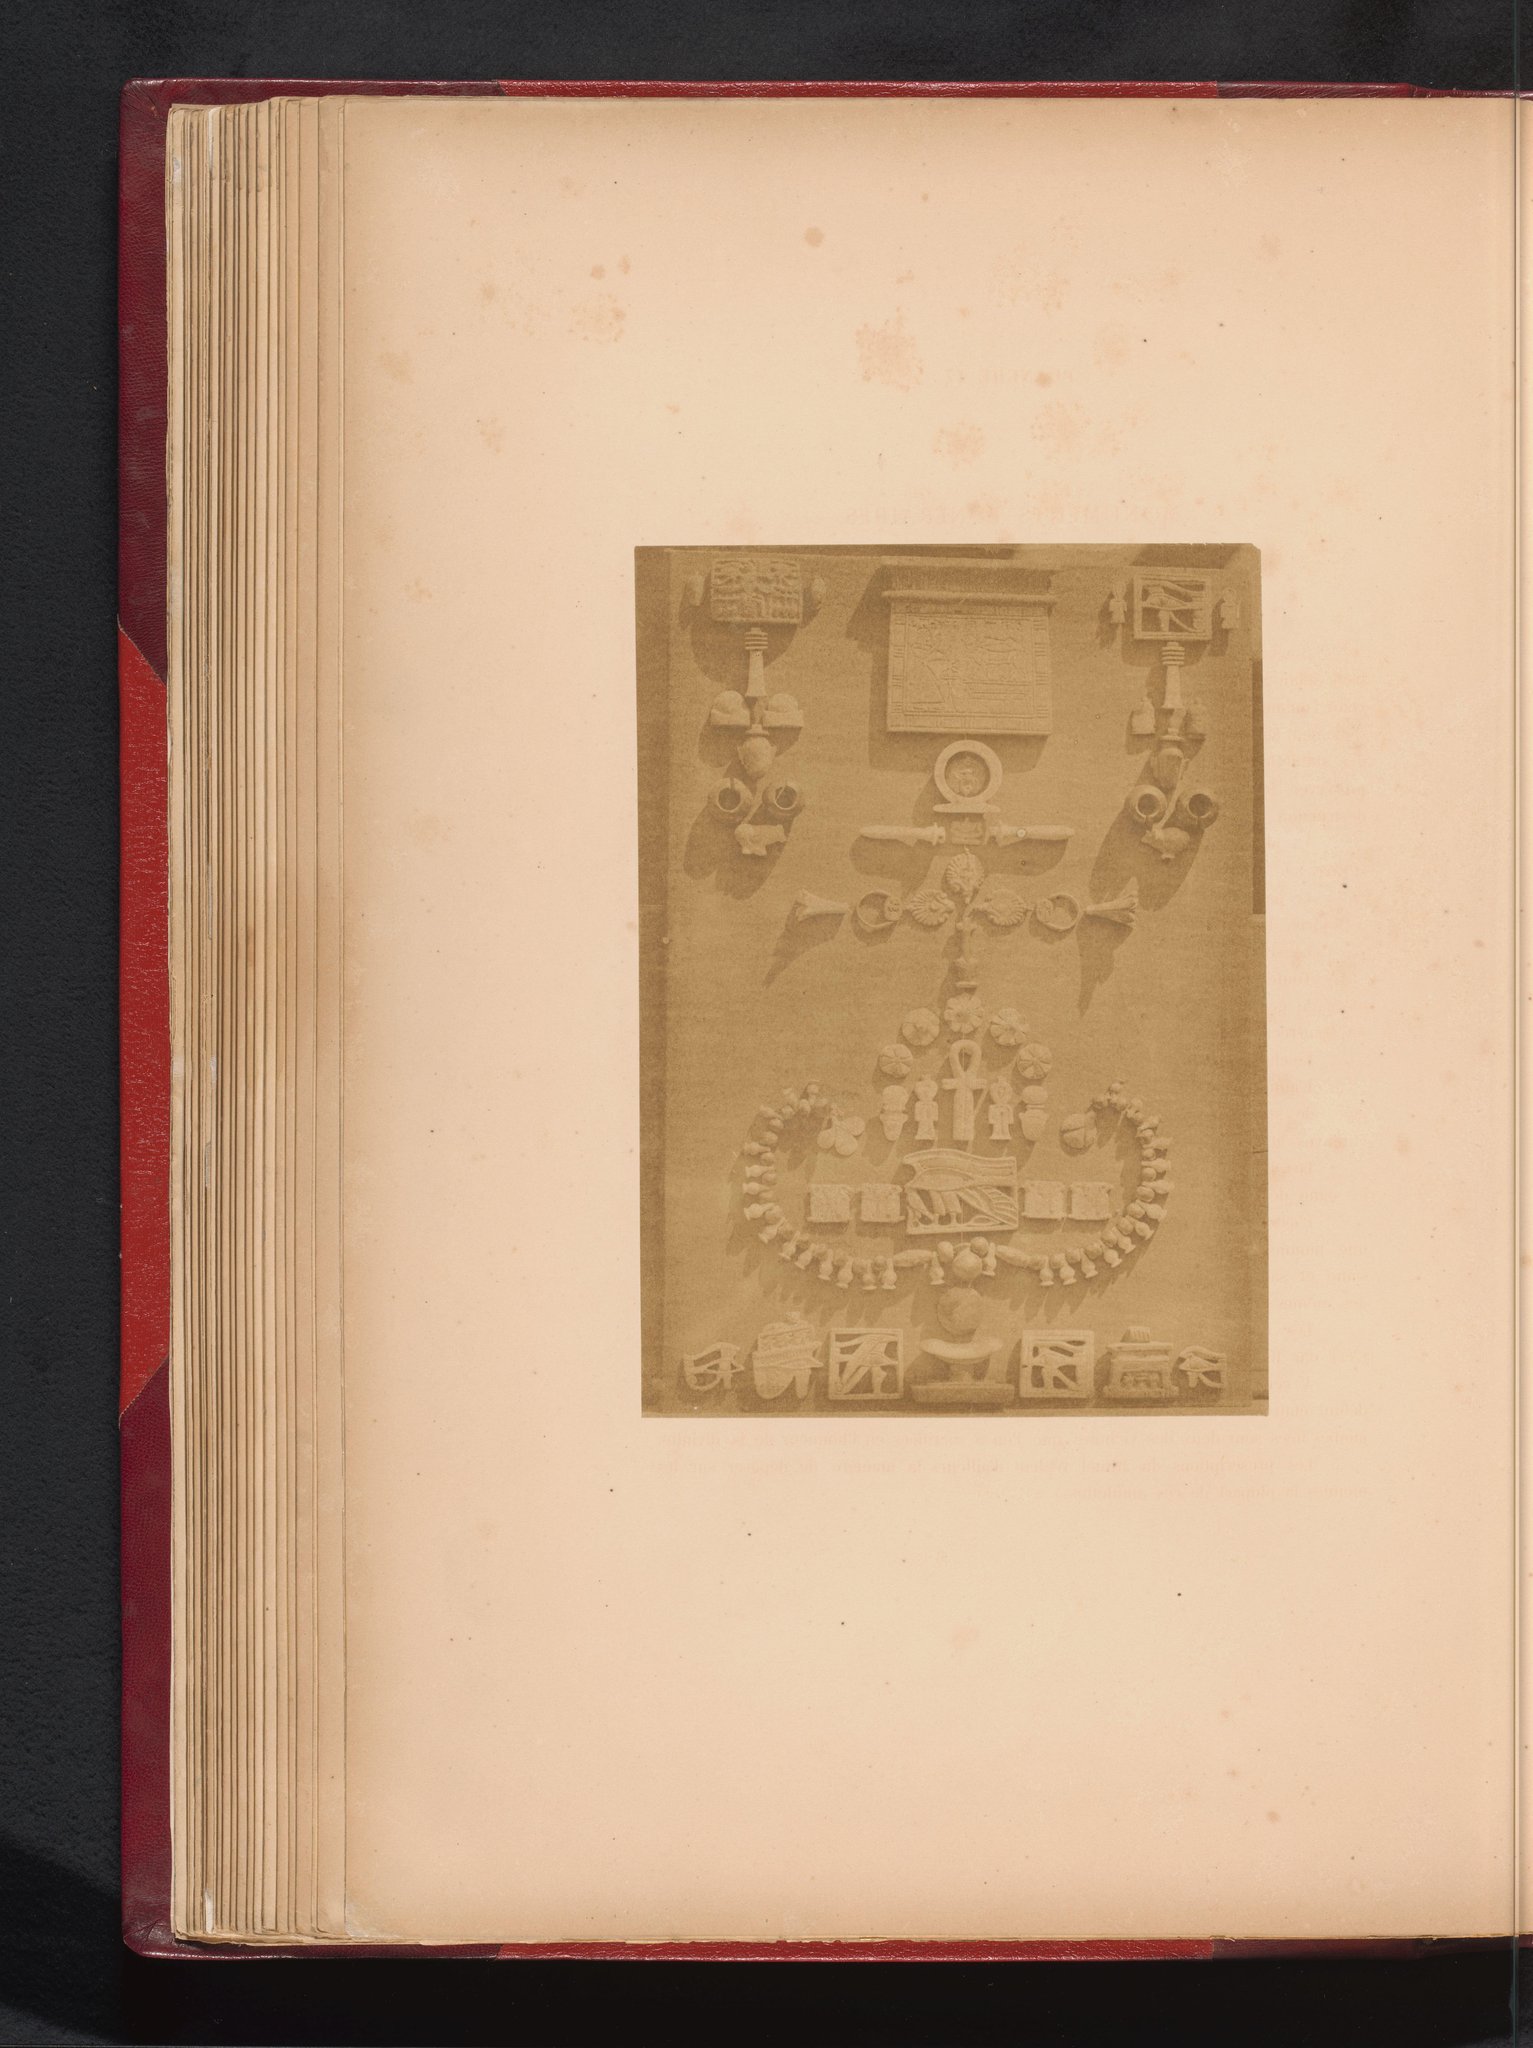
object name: page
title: Amuletten, gevonden in Egyptische graven, in het Boulaq Museum in Caïro, Egypte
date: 1866-1871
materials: photographic support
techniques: albumen print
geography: cairo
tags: amulet, talisman, permanent exhibition, museum